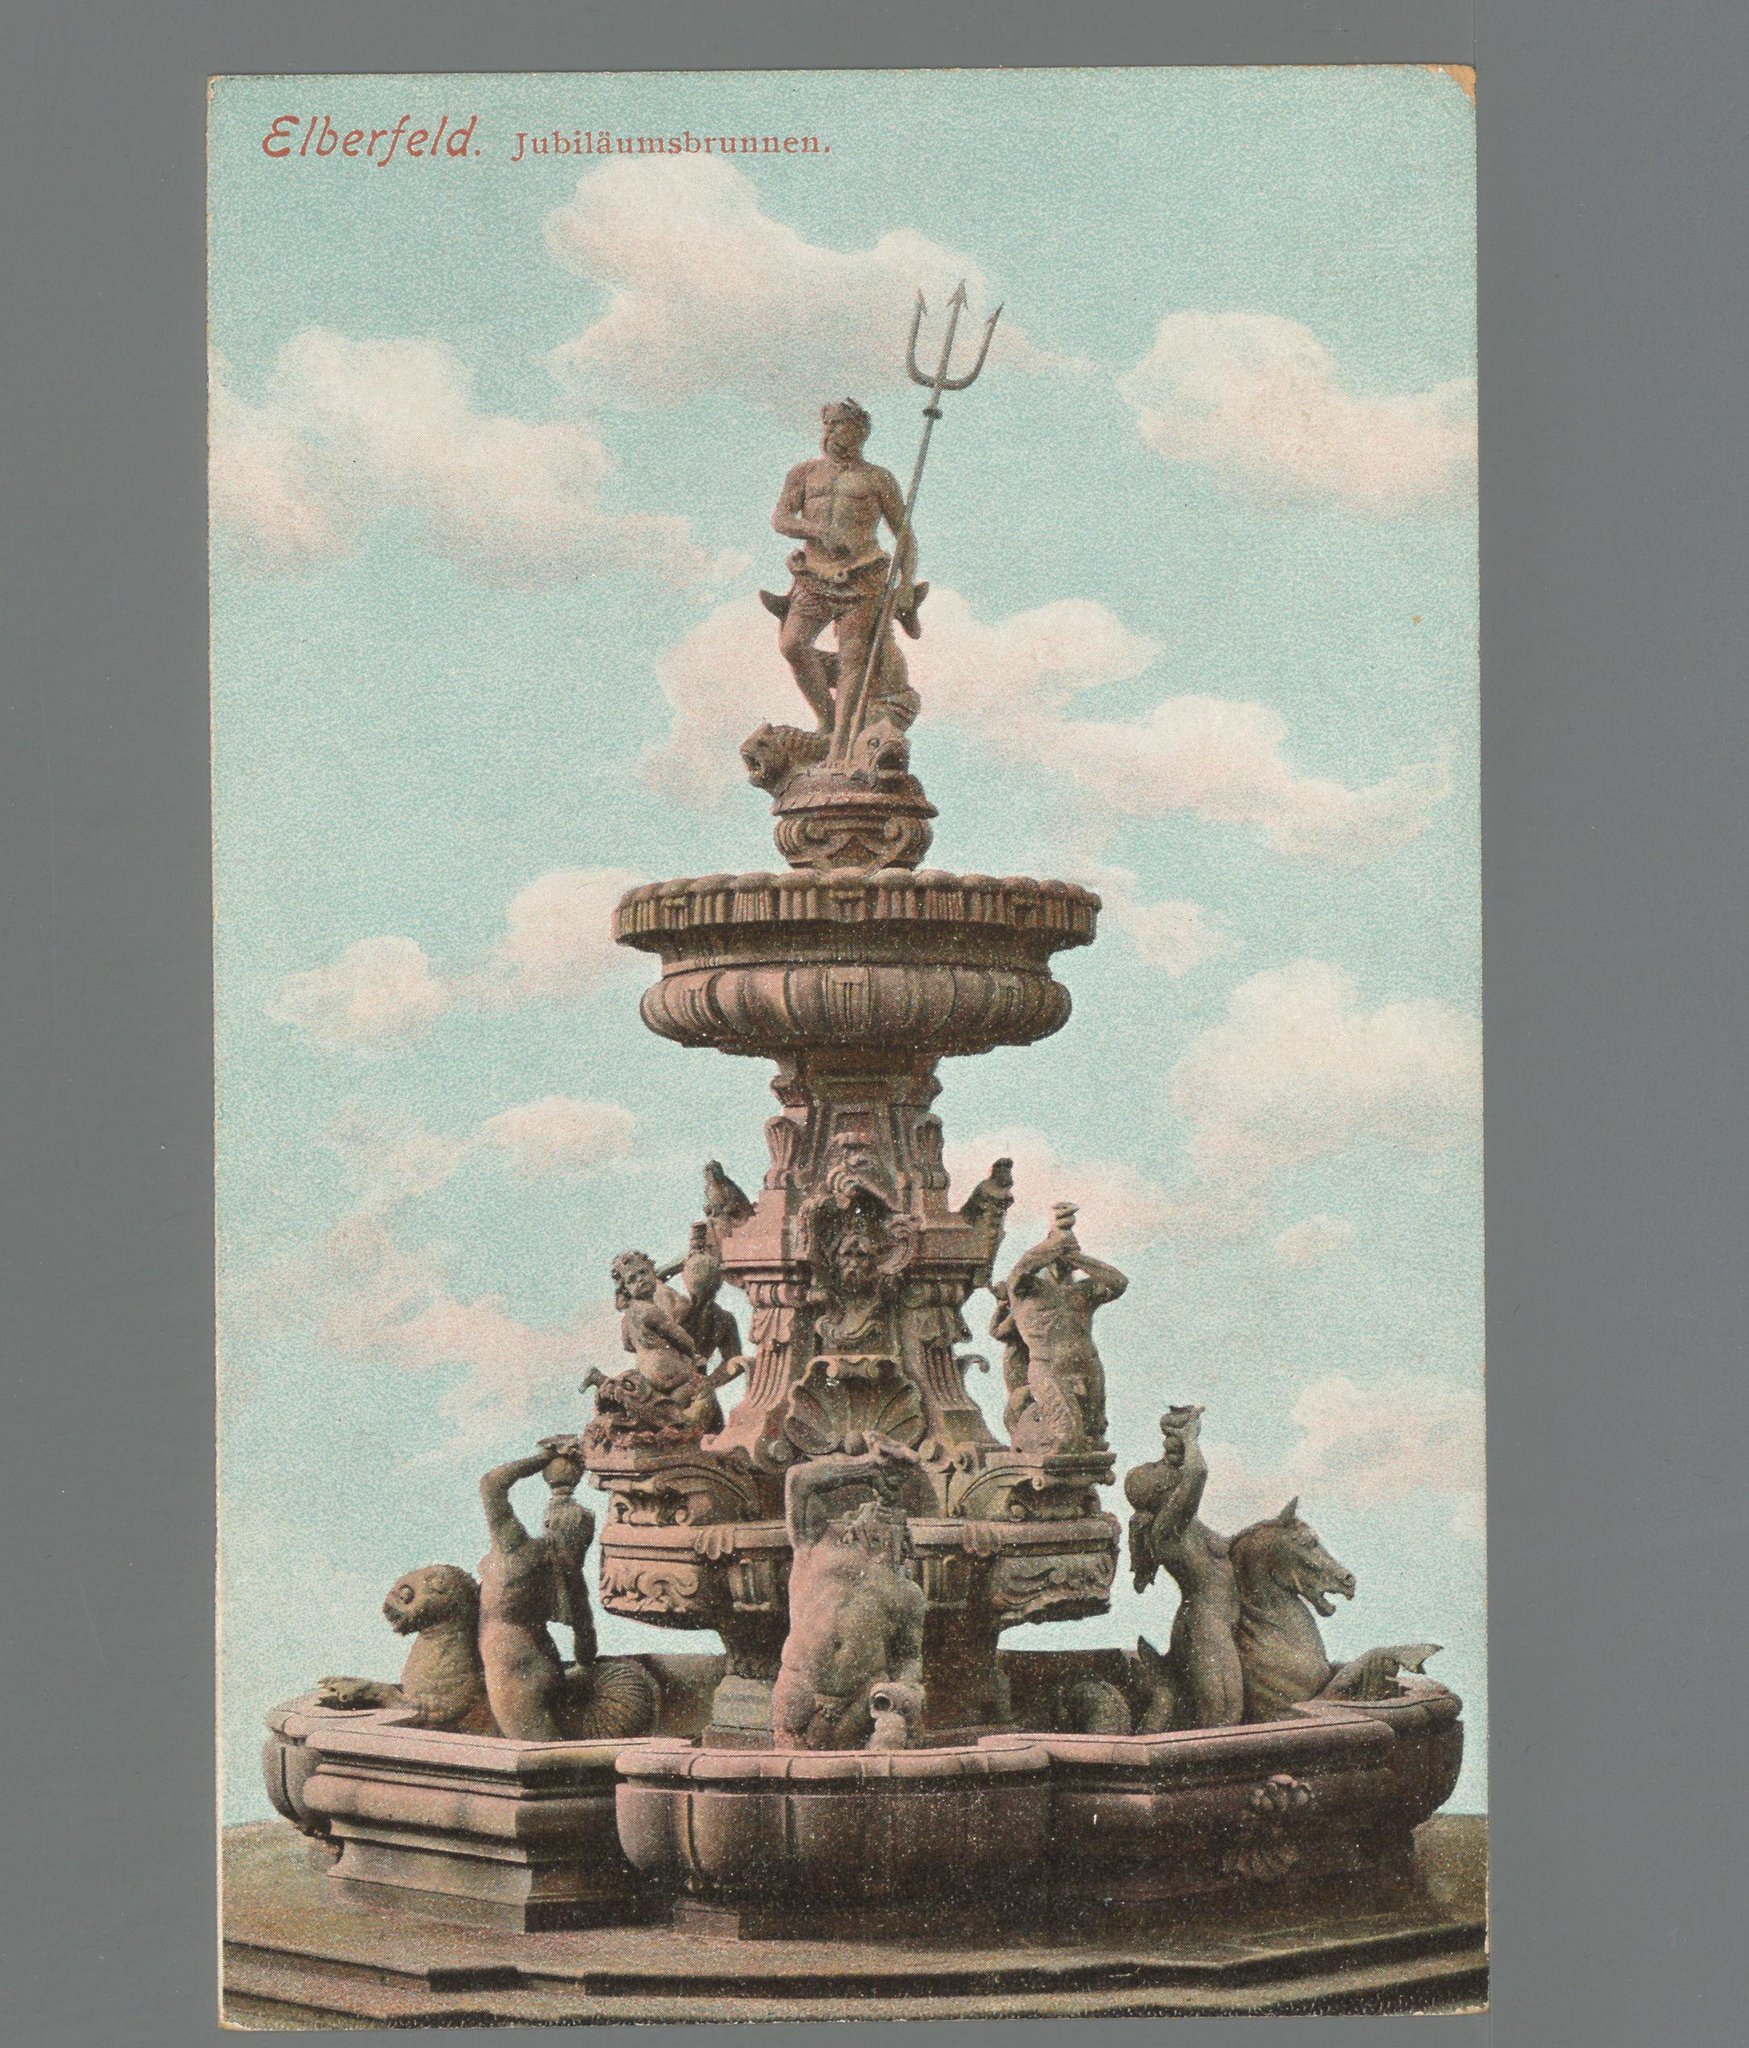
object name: photomechanical print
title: Elberfeld. Jubiläumsbrunnen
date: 1905-1930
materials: cardboard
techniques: lithograph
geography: elberfeld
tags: ornamental fountain